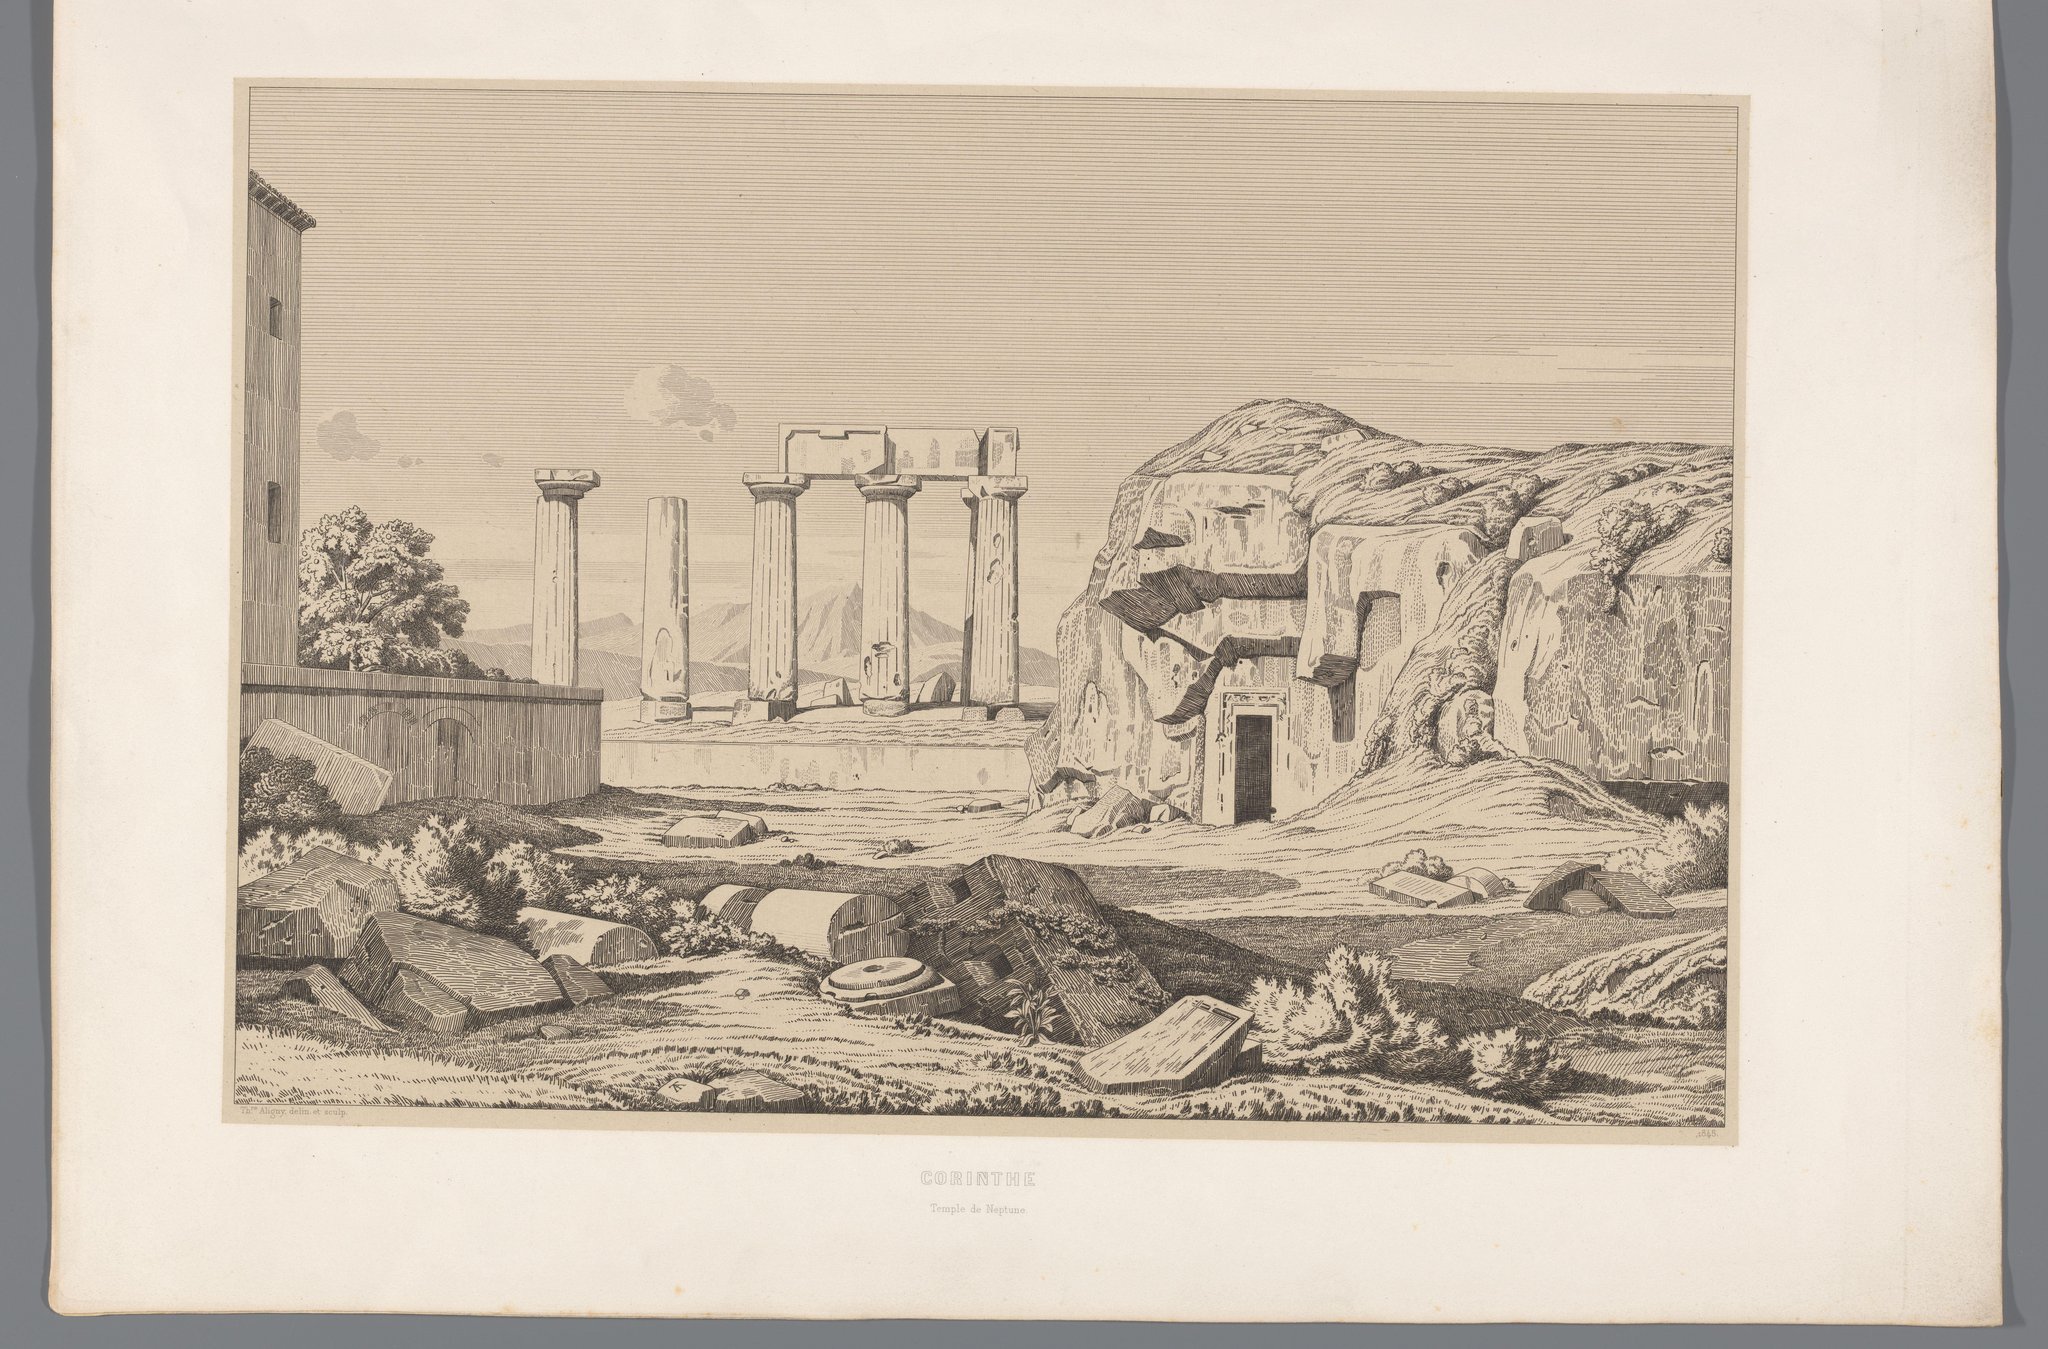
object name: print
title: Vues des sites les plus célèbres de la Grèce antique (...)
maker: claude-félix-théodore caruelle d aligny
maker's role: print maker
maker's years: 1798-1871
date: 1845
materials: paper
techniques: etching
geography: france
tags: landscape with ruins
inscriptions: collector's mark: Lugt 2760, collector's mark: Lugt 2228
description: Maakt deel uit van een omslag met tien prenten.